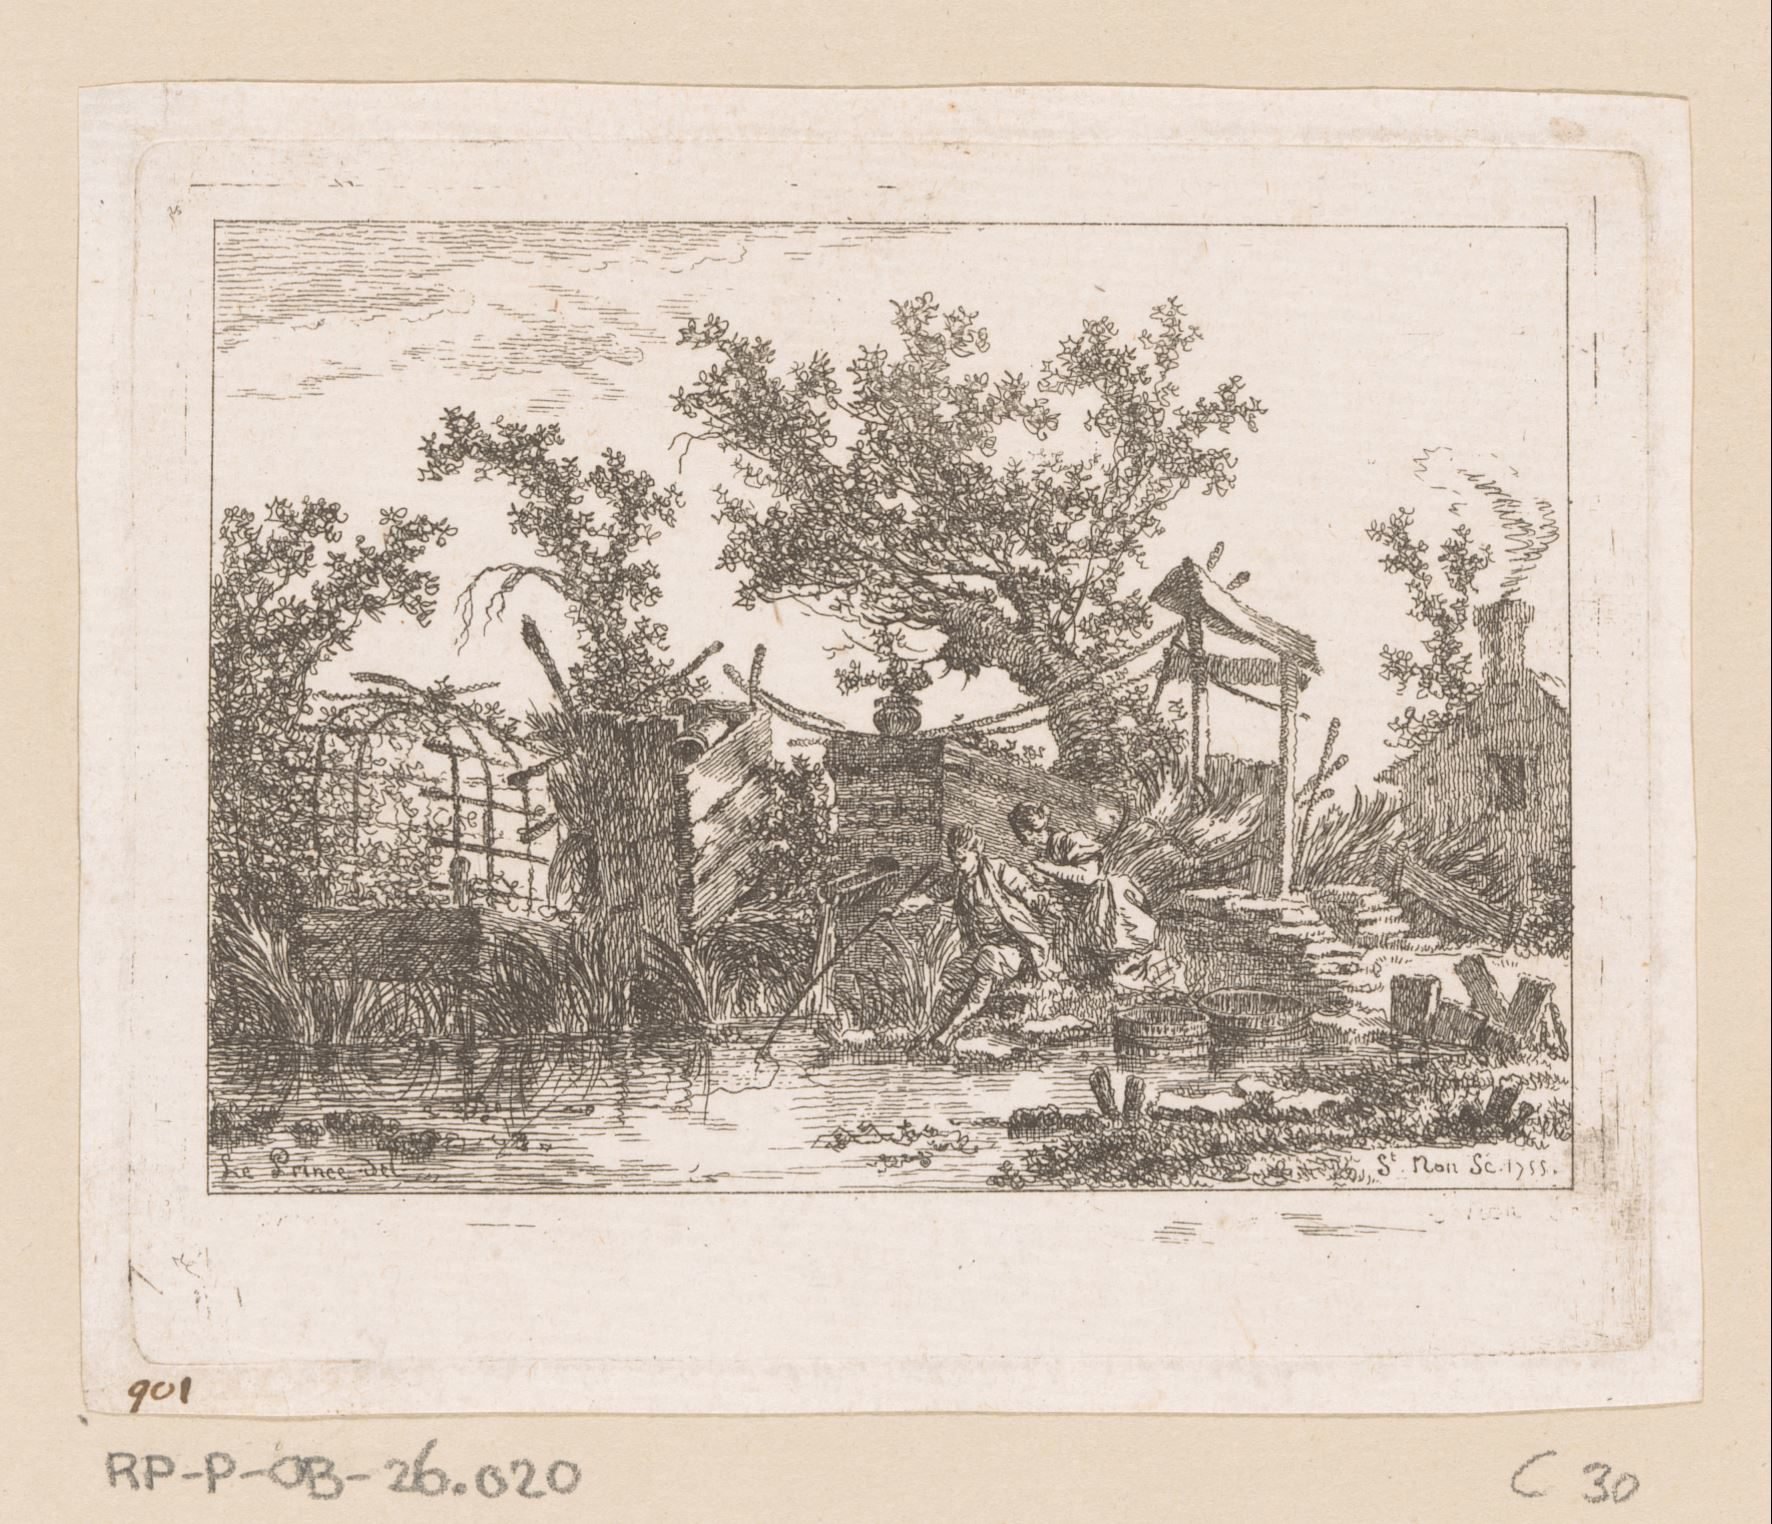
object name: print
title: Landschap met vissend paar aan een meer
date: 1755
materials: paper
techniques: etching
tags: landscapes with waters, waterscapes, seascapes (in the temperate zone), fishing (sports)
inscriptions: collector's mark: Lugt 240